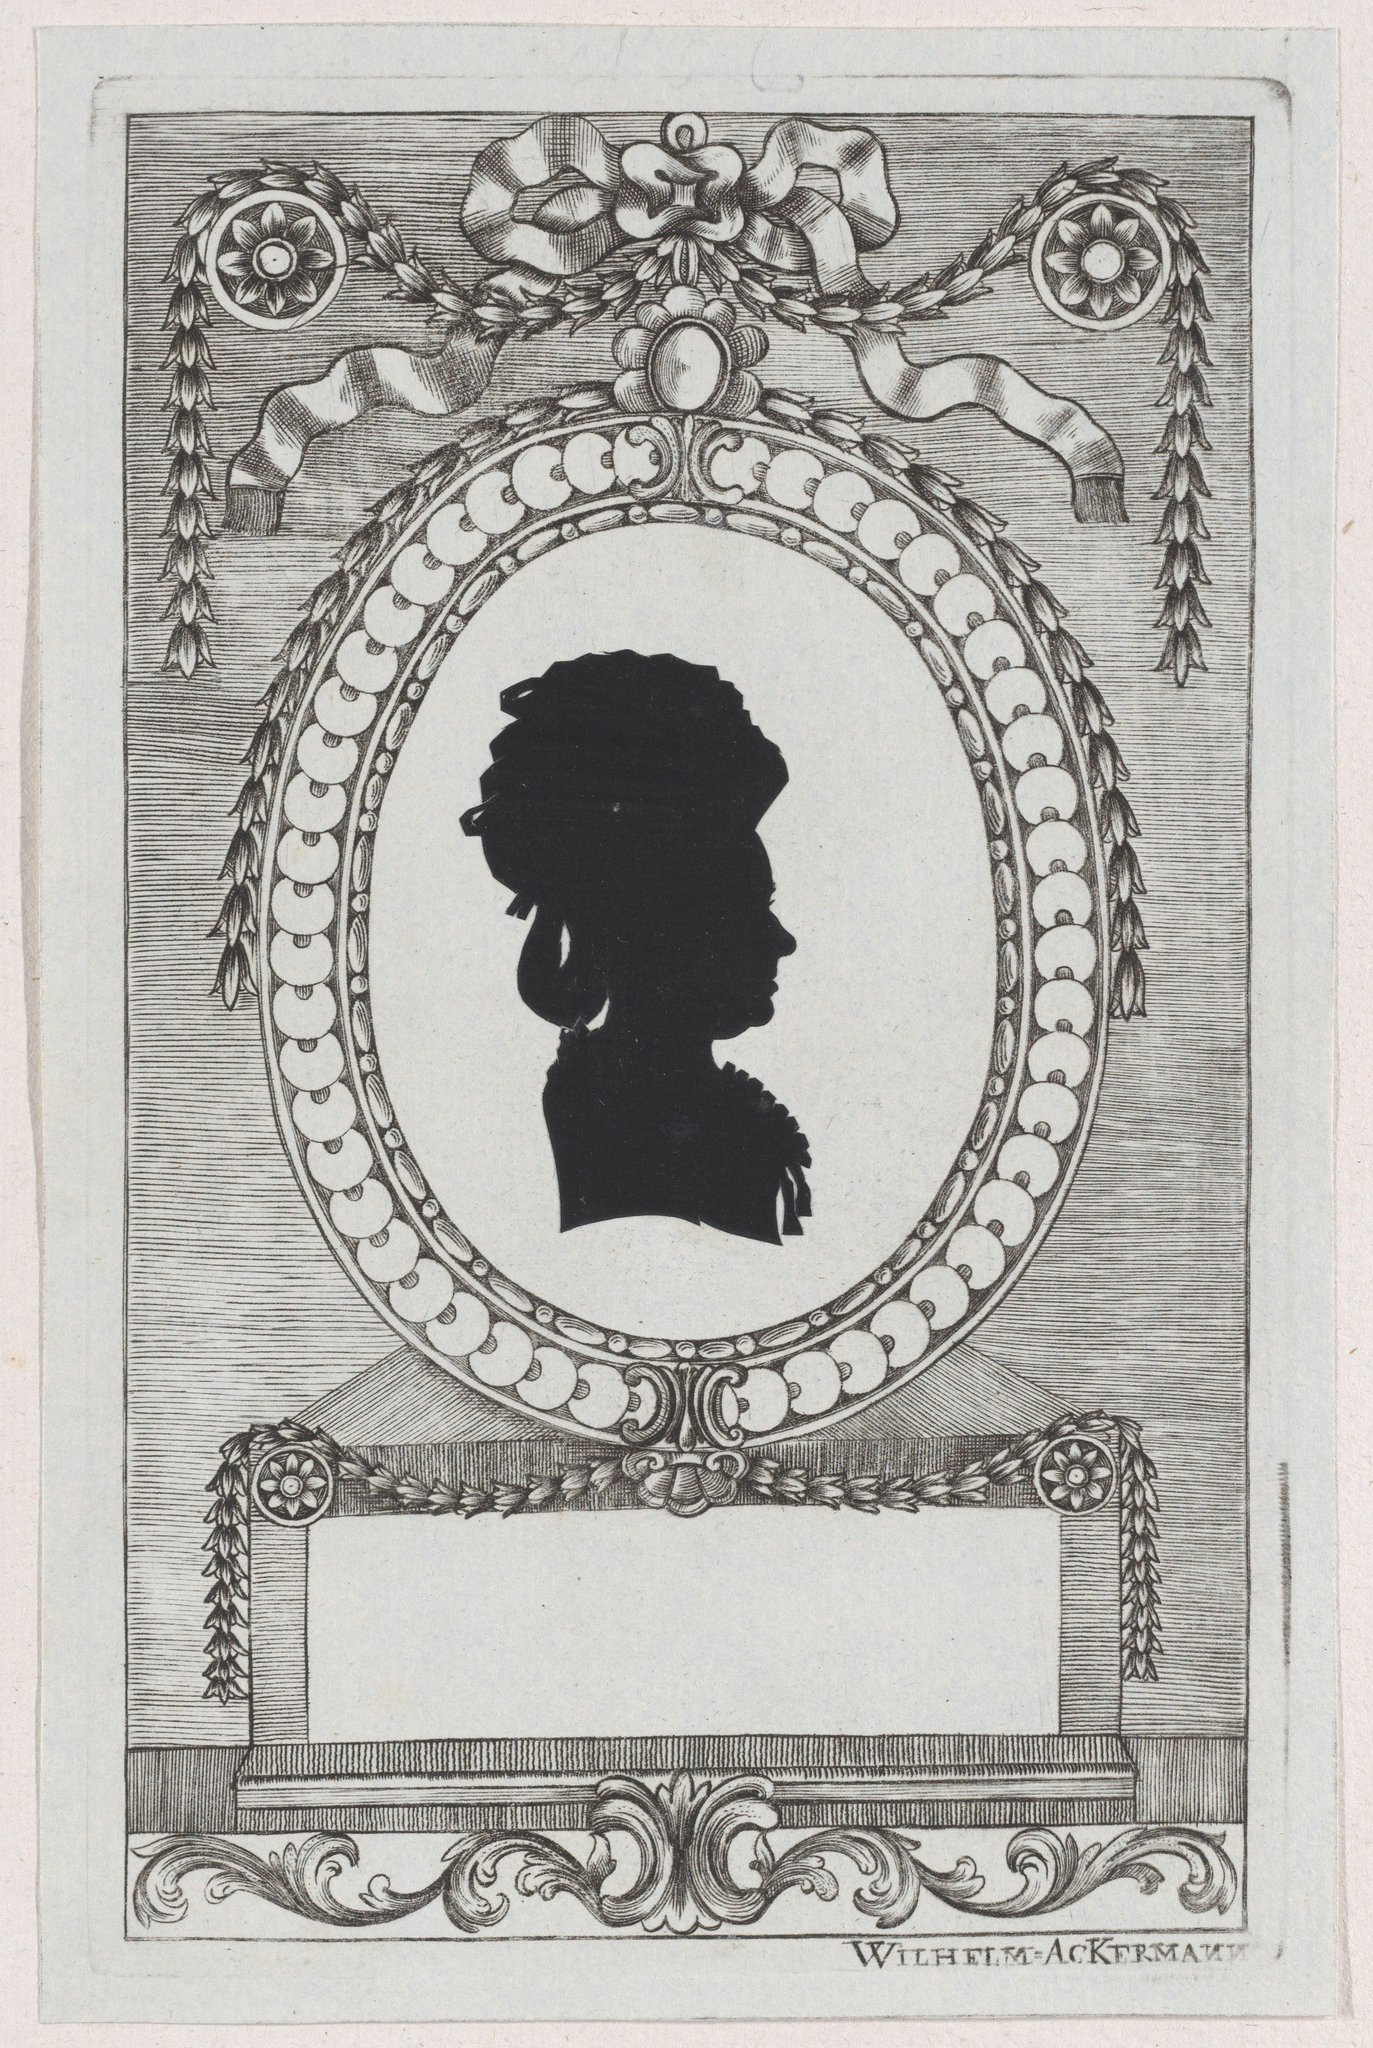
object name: print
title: Silhouette of Gräfin Coreth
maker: wilhelm ackermann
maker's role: artist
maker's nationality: german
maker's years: 1764-1834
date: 1784-1834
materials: paper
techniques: cutting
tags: women